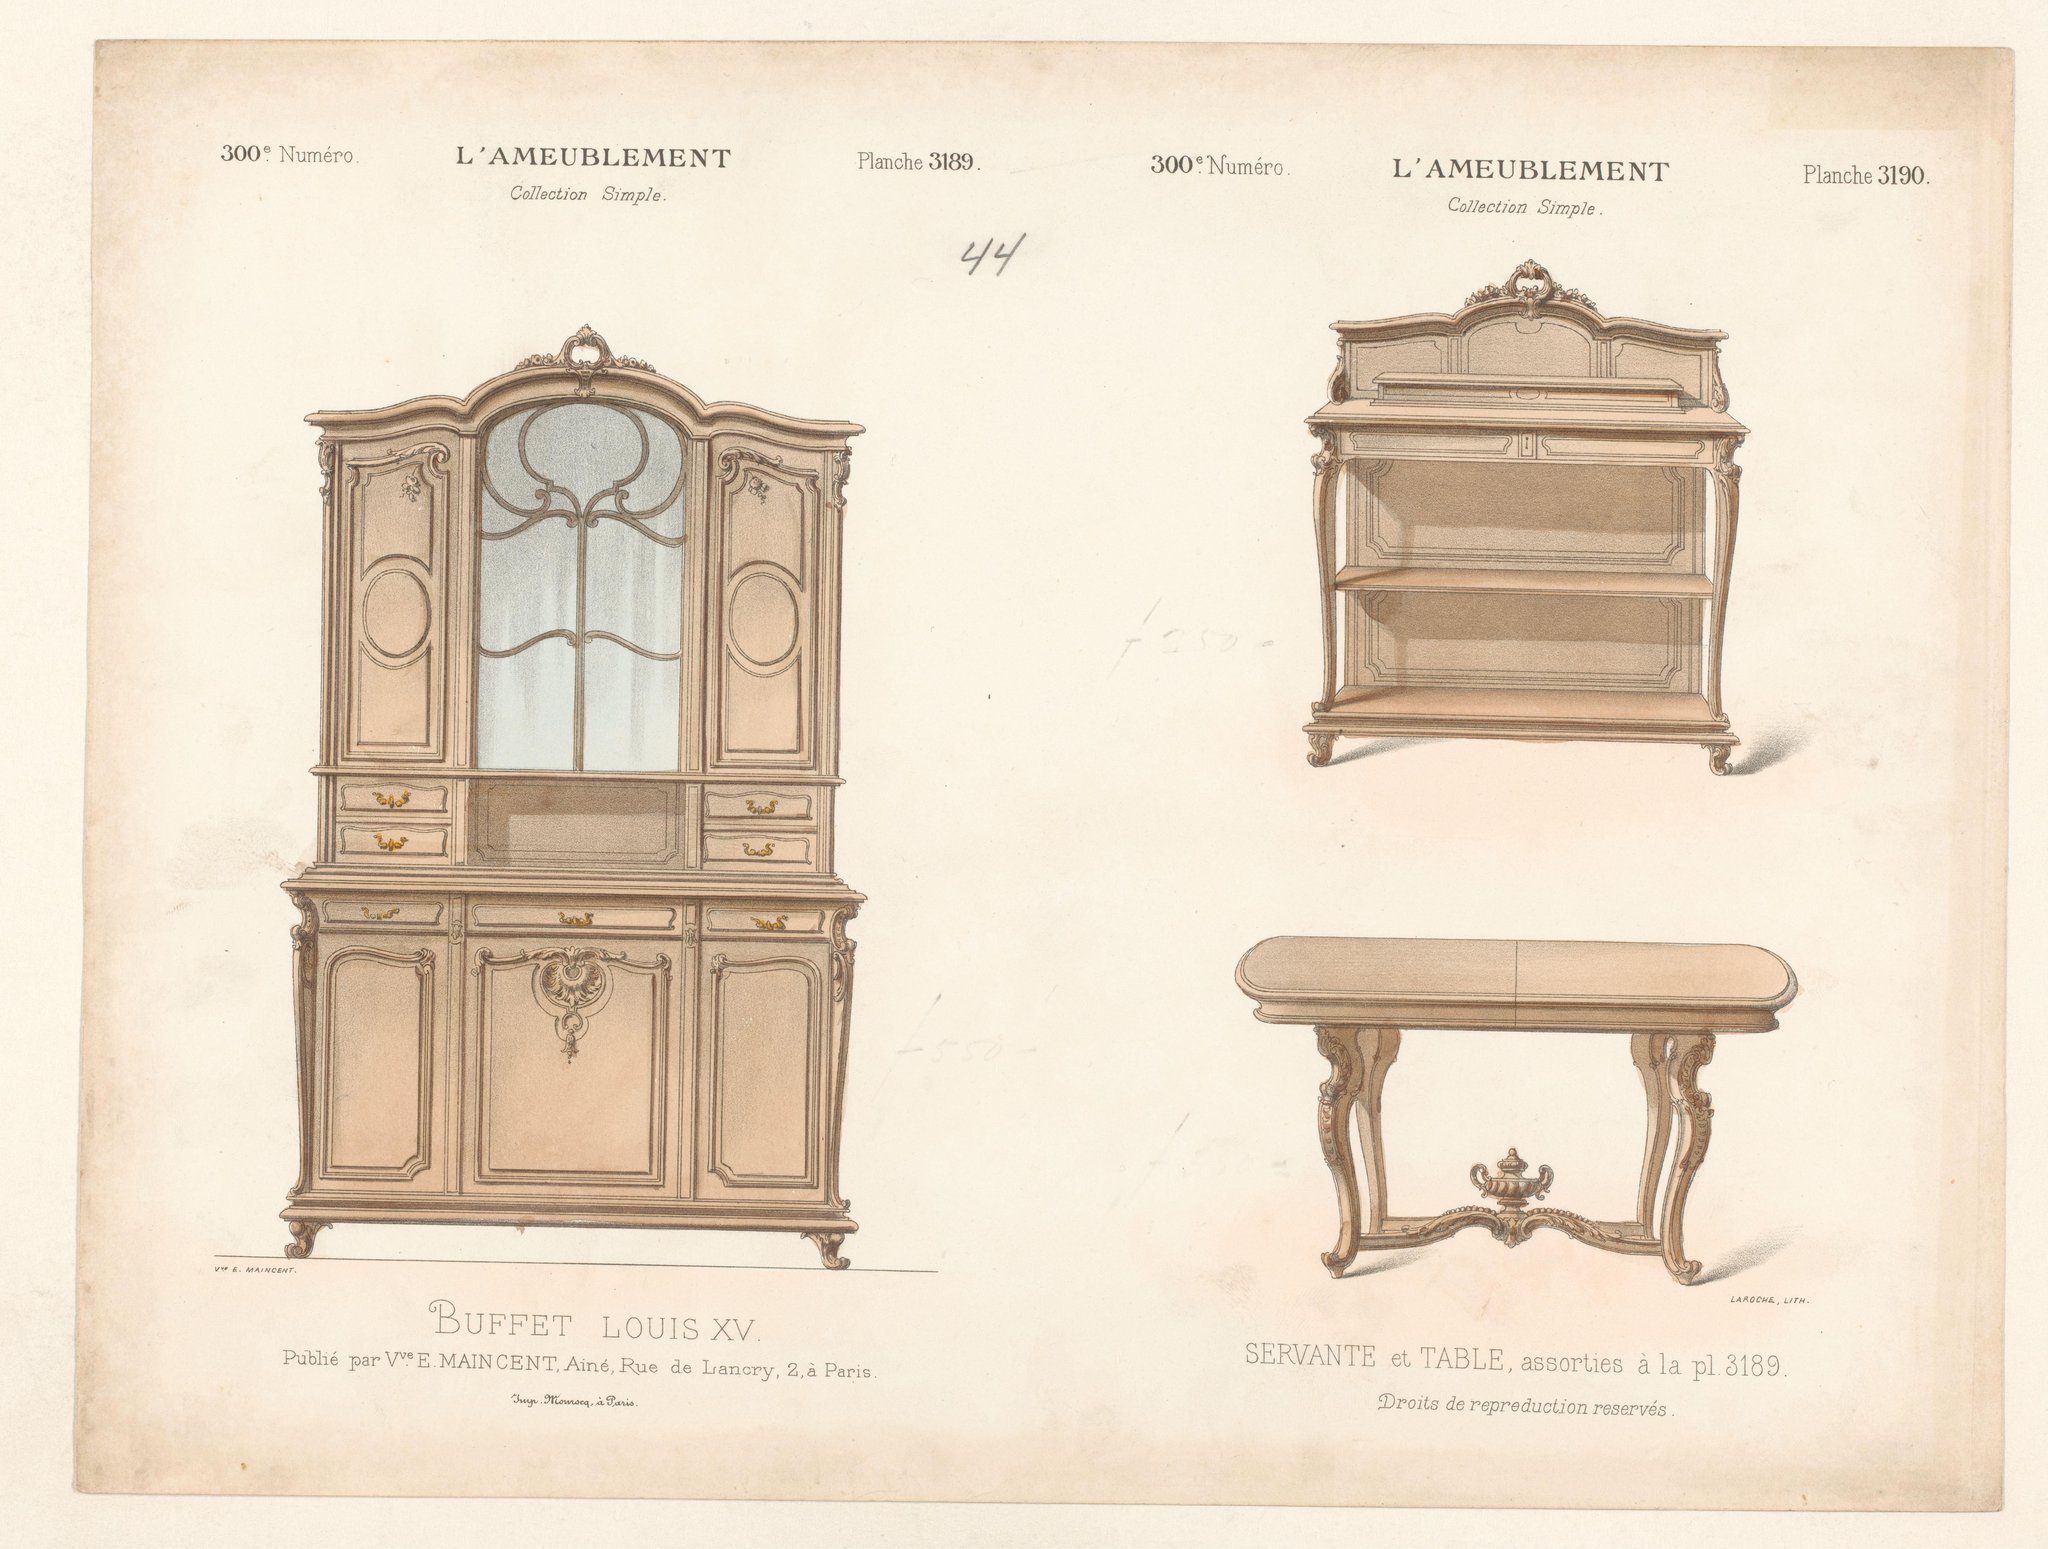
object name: print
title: L'ameublement / Collection Simple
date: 1895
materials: paper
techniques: hand coloring, lithograph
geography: paris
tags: furniture for storage, table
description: Een buffetkast, lage open kast en tafel in de Lodewijk XV-stijl. Prent uit 300e Livraison.